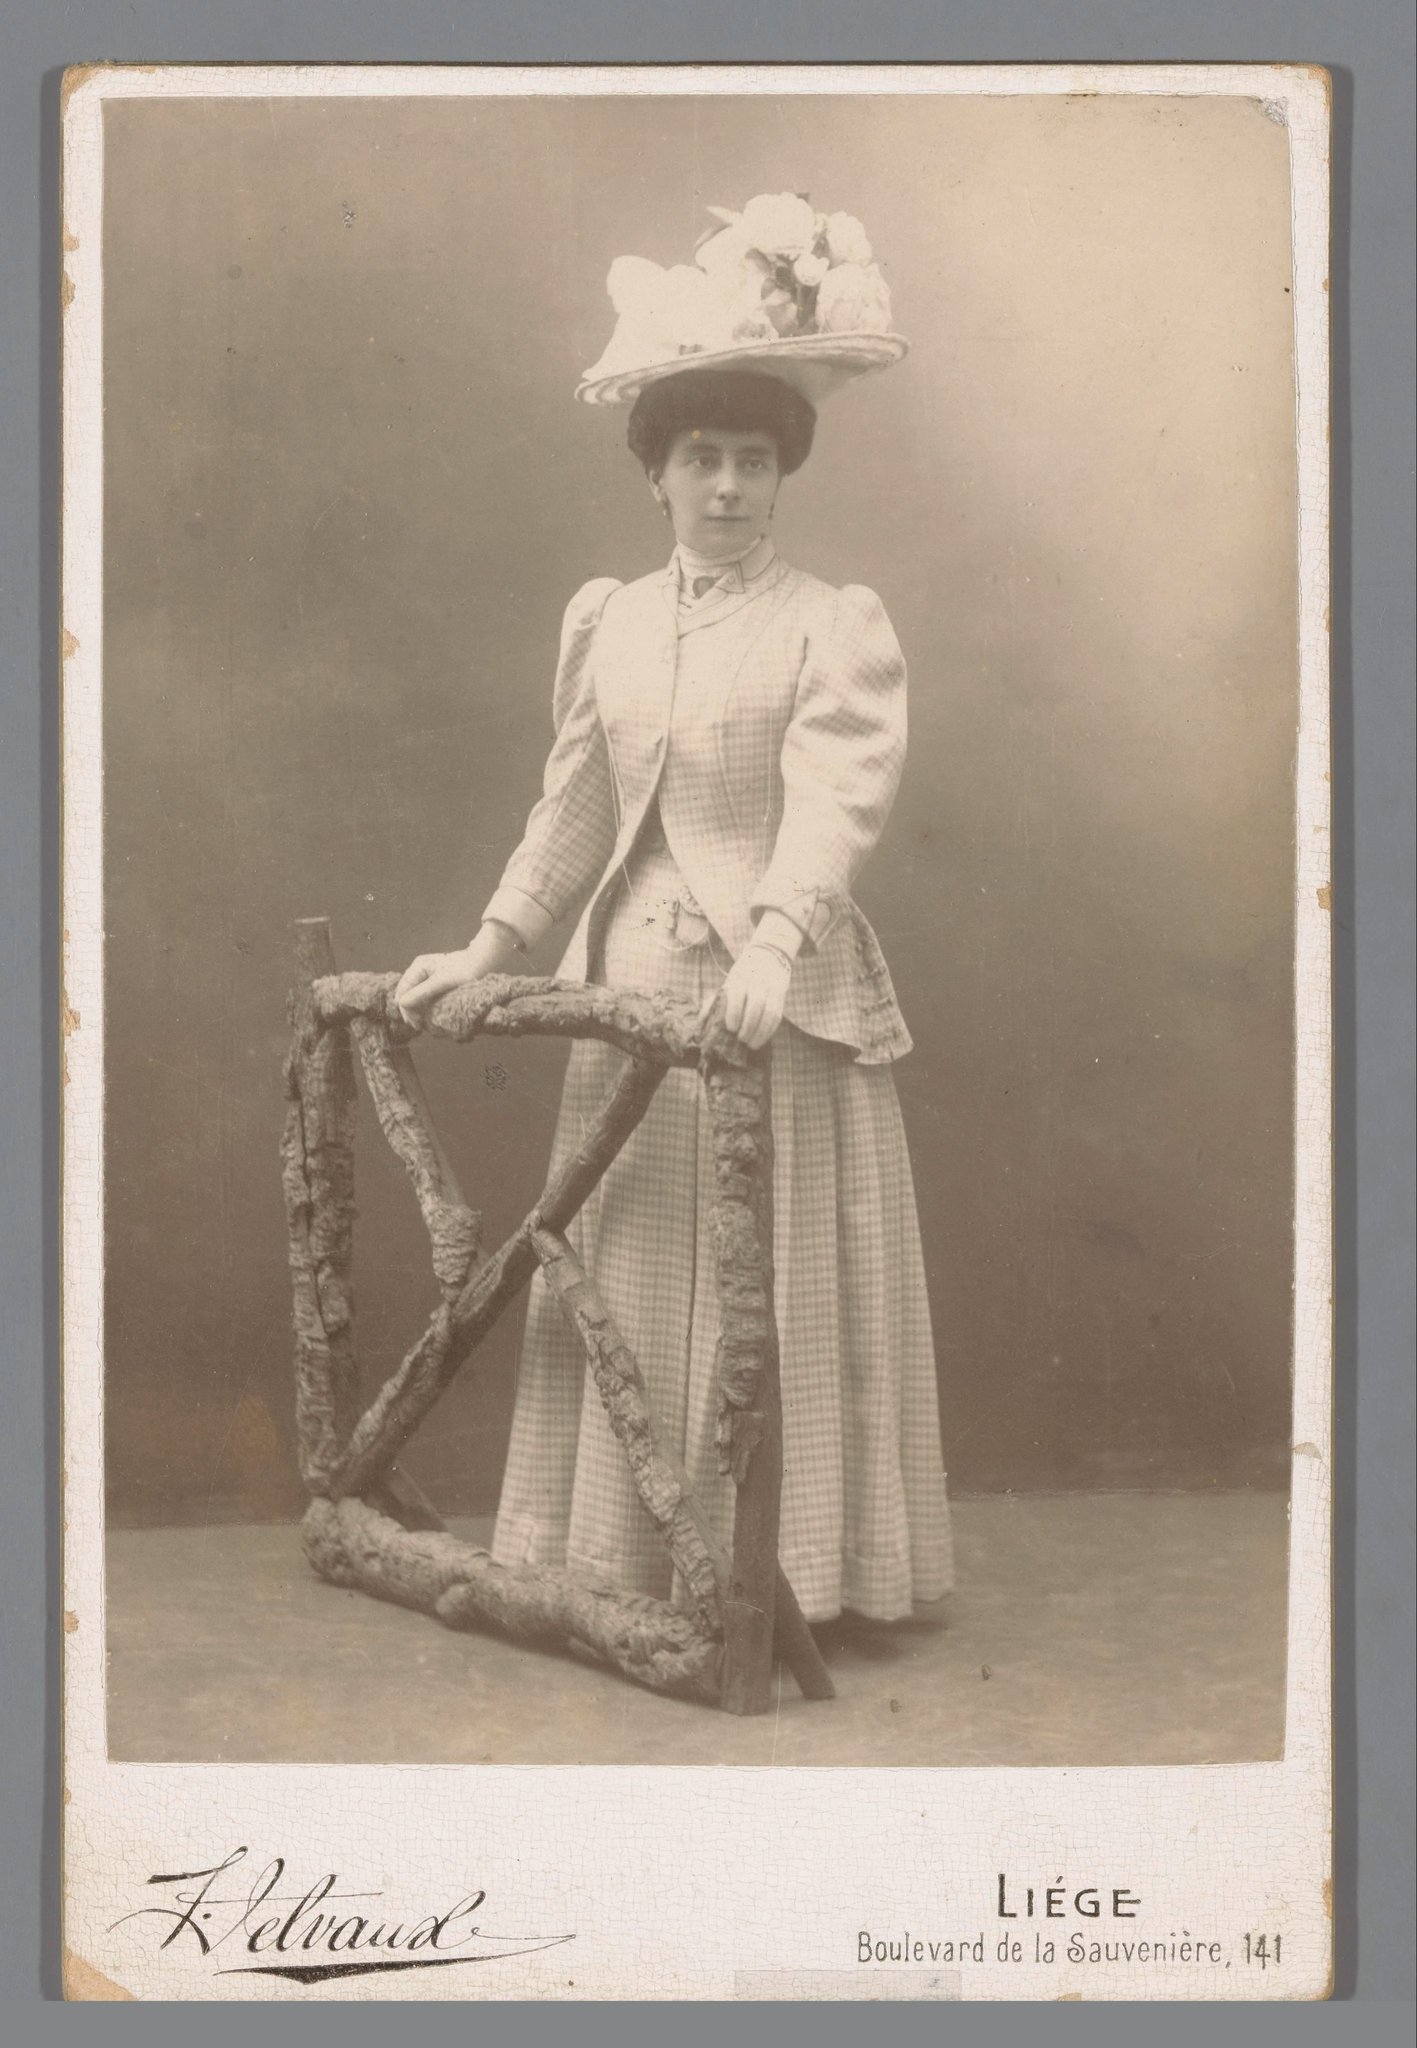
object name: cabinet photograph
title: Portret van een vrouw met een hoed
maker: jules delvaux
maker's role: fotograaf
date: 1900-1910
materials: cardboard, photographic support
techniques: matte daylight collodion silver print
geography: liège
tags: adult woman, head-gear: hat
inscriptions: name: ‘Photographie Zeyen J. Delvaux [...] 141, Boulevard de la Sauvenière Liége (...)’